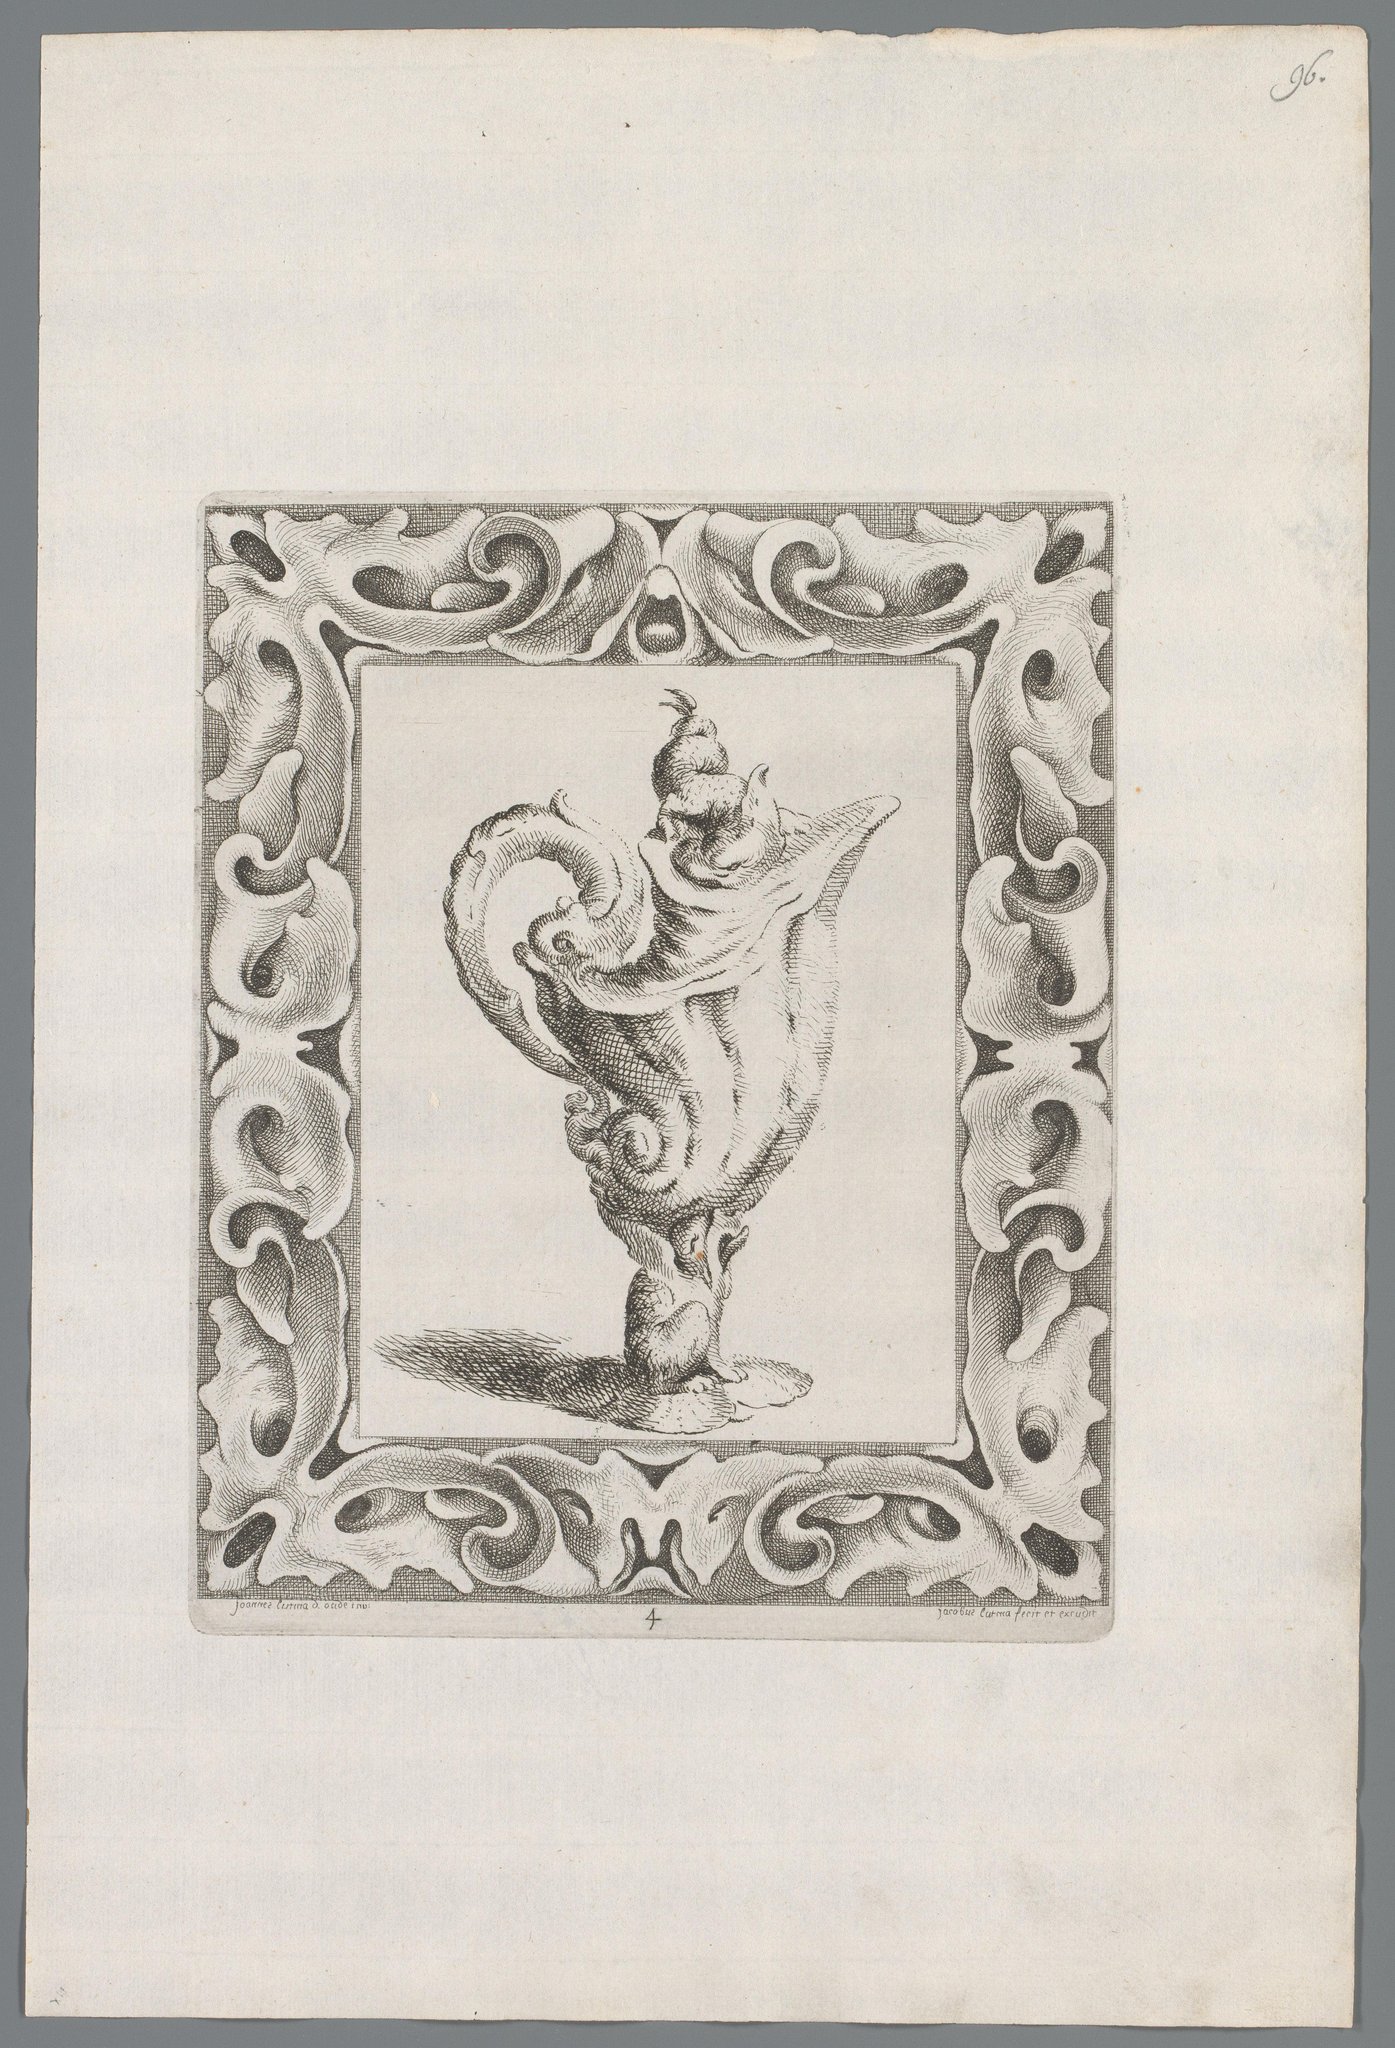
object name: print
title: Festivitates aurifarbis / Verscheyde snakerijen dienstich voor goutsmits, beelthouwers, steenhouwers, en alle die de const beminnen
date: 1654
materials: paper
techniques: engraving, etching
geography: amsterdam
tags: auricular ornament, lobe style ~ ornament, jar, jug (used as drinking-vessel)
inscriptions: collector's mark: Lugt 2760, collector's mark: Lugt 2228